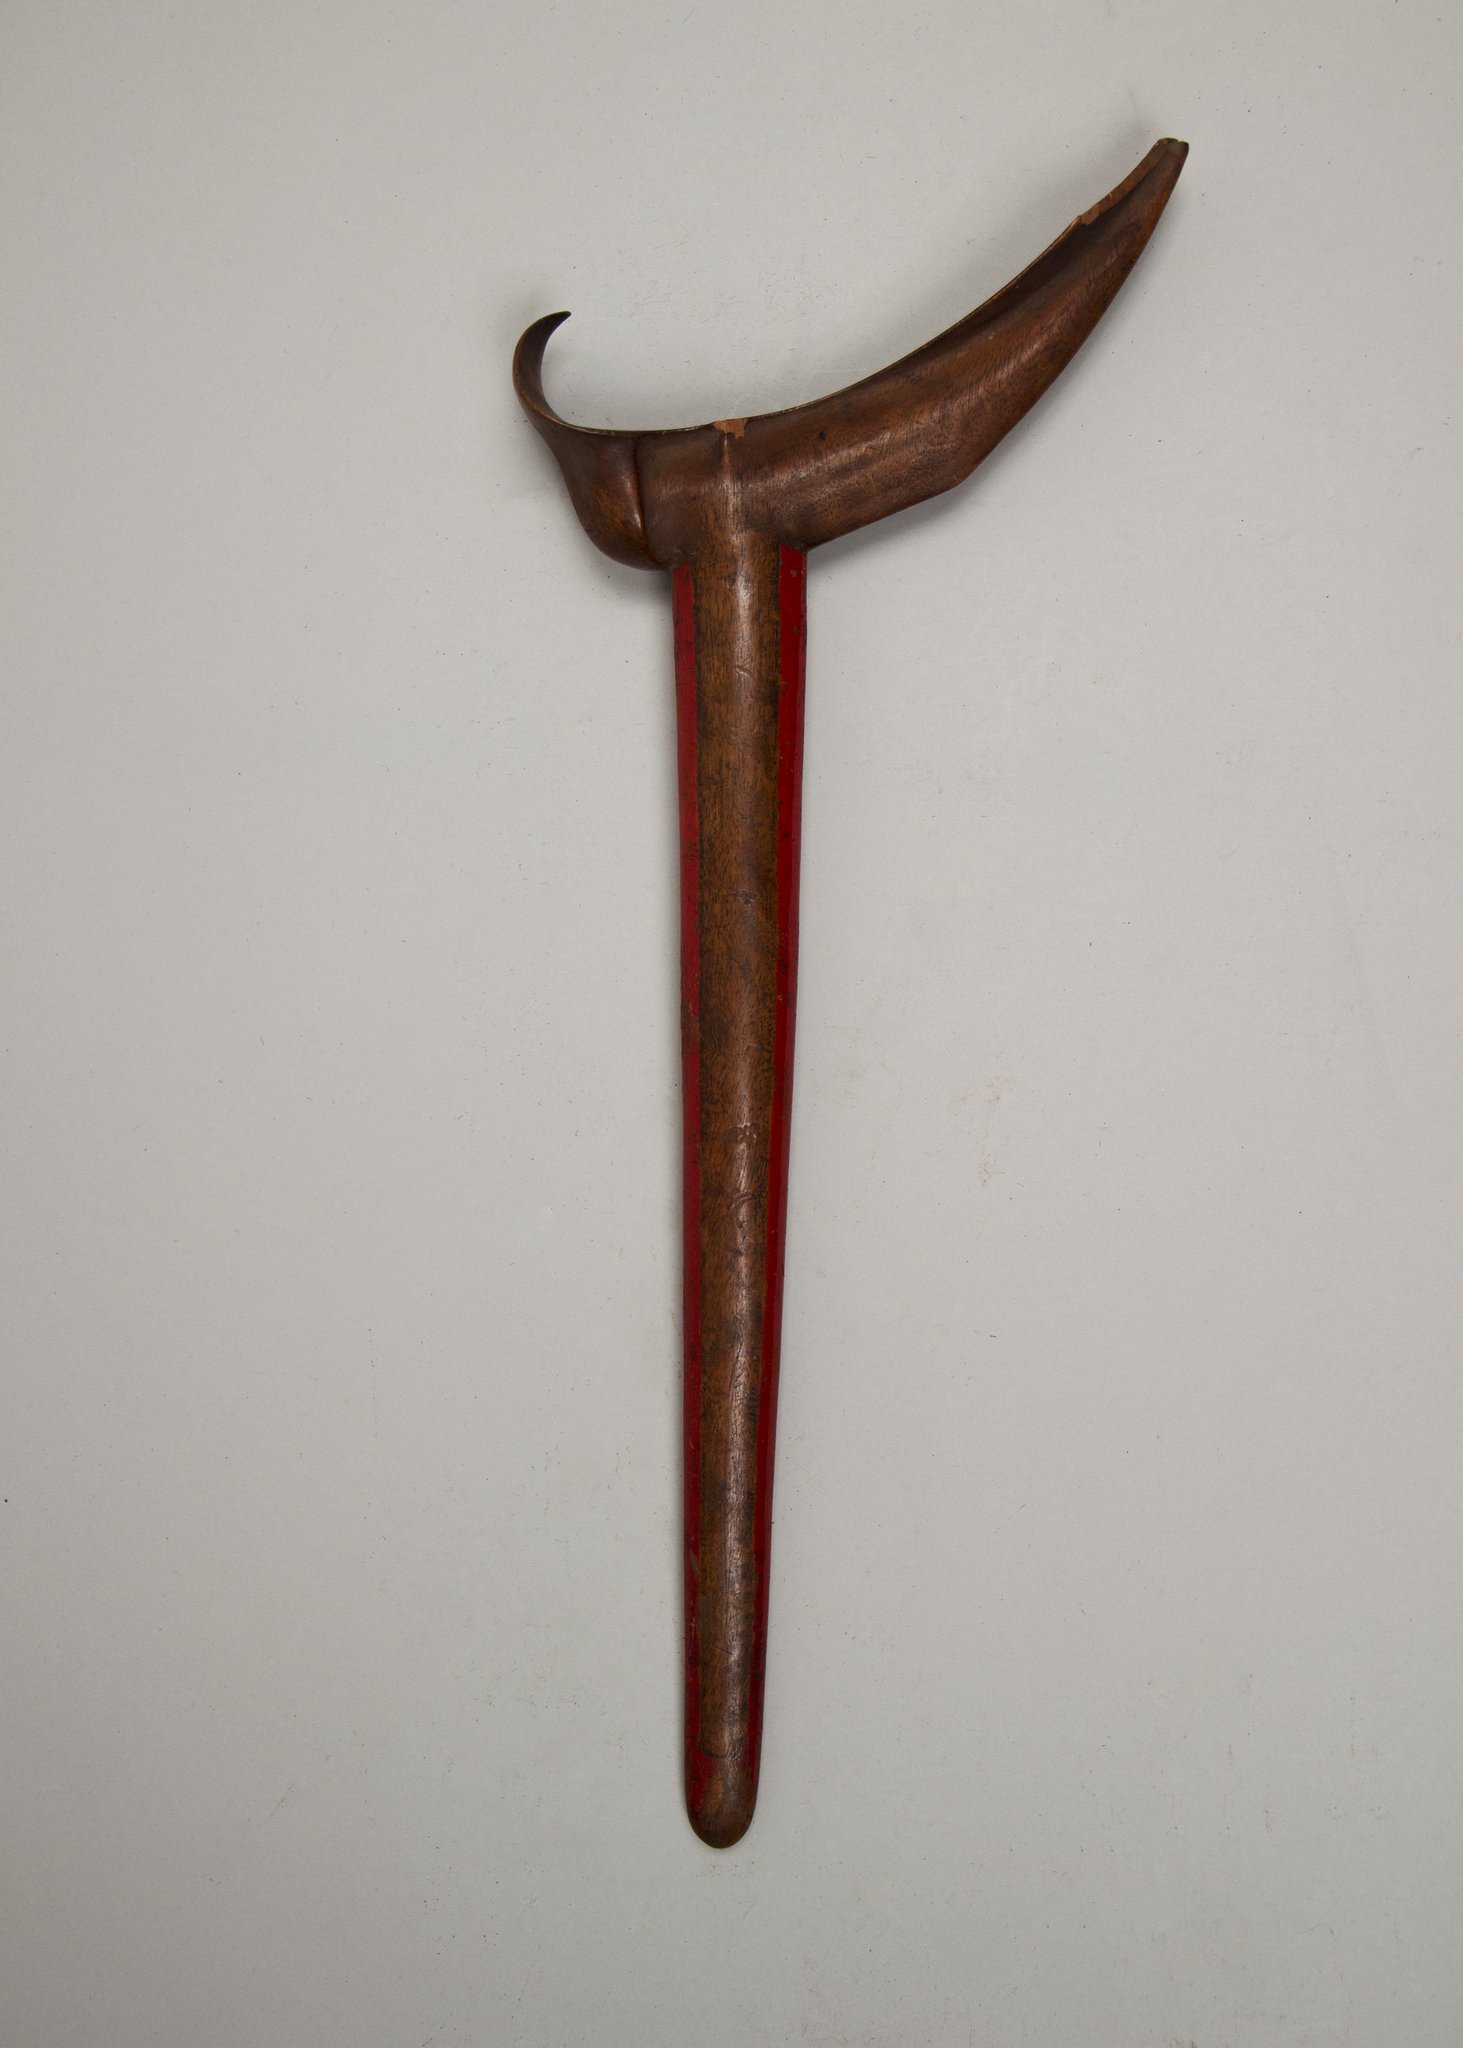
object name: kris with sheath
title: Sheath for a Kris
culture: javanese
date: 1501-1900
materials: gold, ivory, pigment, wood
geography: indonesia